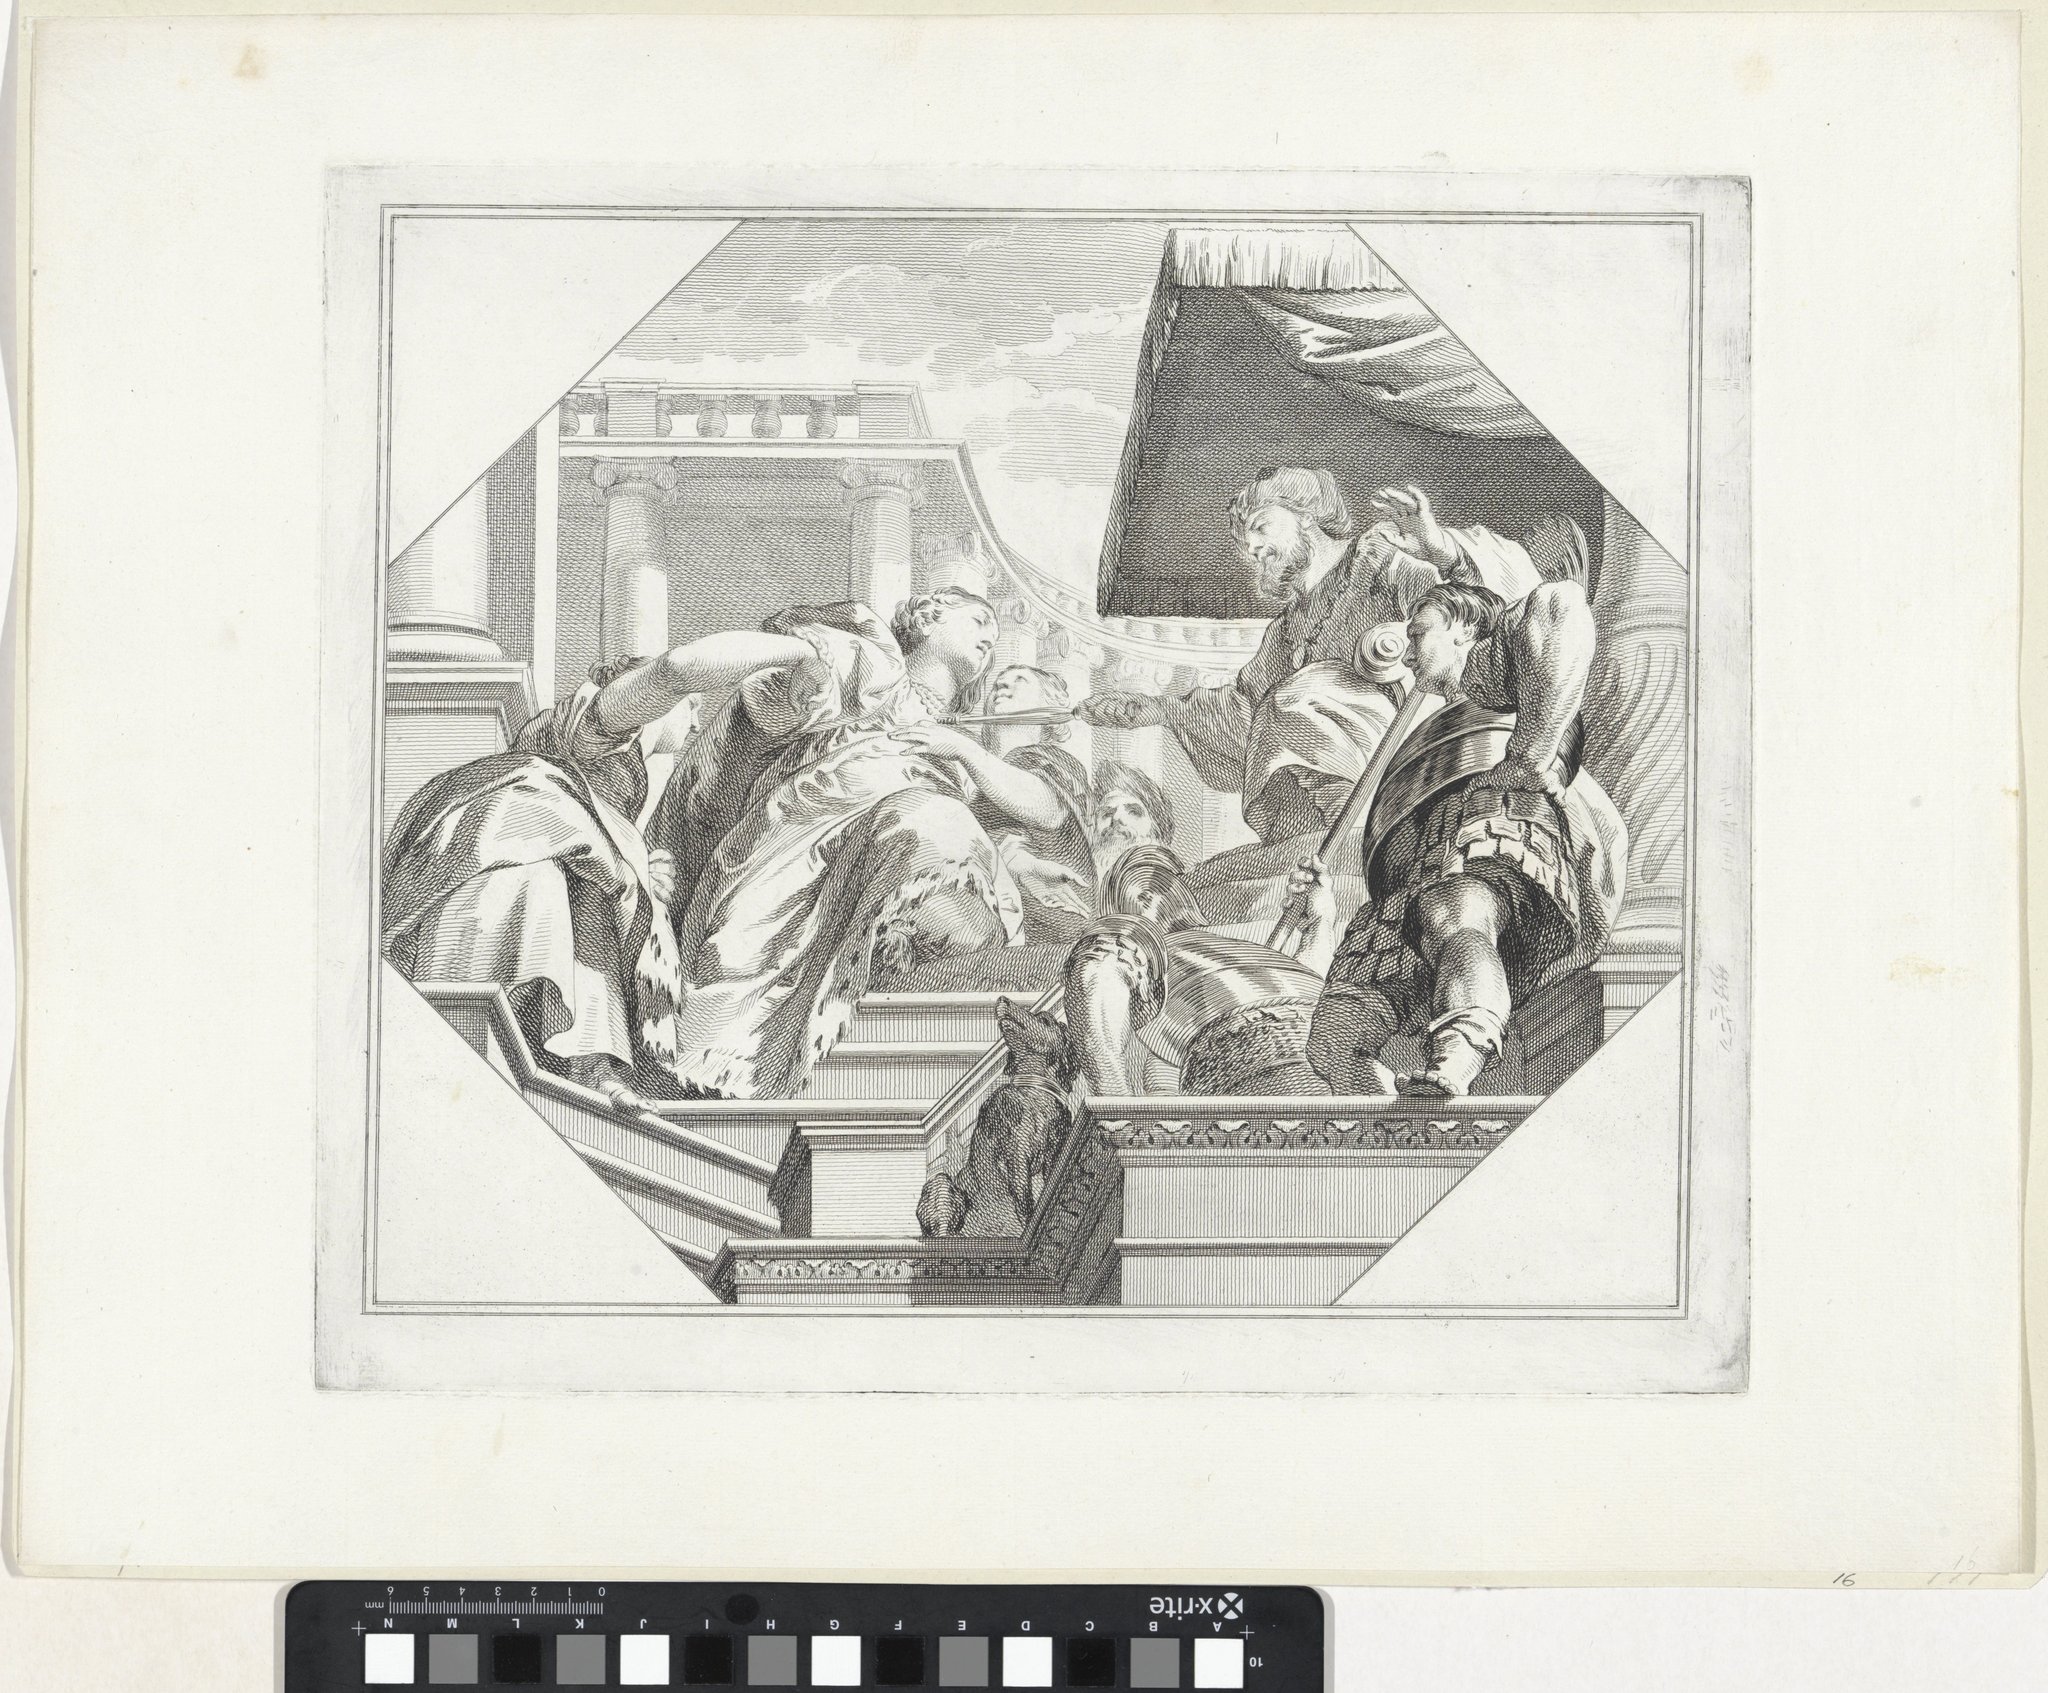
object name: print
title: Koning Ahasverus reikt Ester zijn gouden scepter toe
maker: jan punt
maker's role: draughtsman, print maker, publisher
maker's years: 1711-1779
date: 1751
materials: paper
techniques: engraving, etching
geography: amsterdam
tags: ahasuerus holds out his sceptre to esther (esther usually kneeling)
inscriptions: collector's mark: Lugt 240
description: Koning Ahasverus op zijn troon reikt Ester zijn gouden scepter aan.